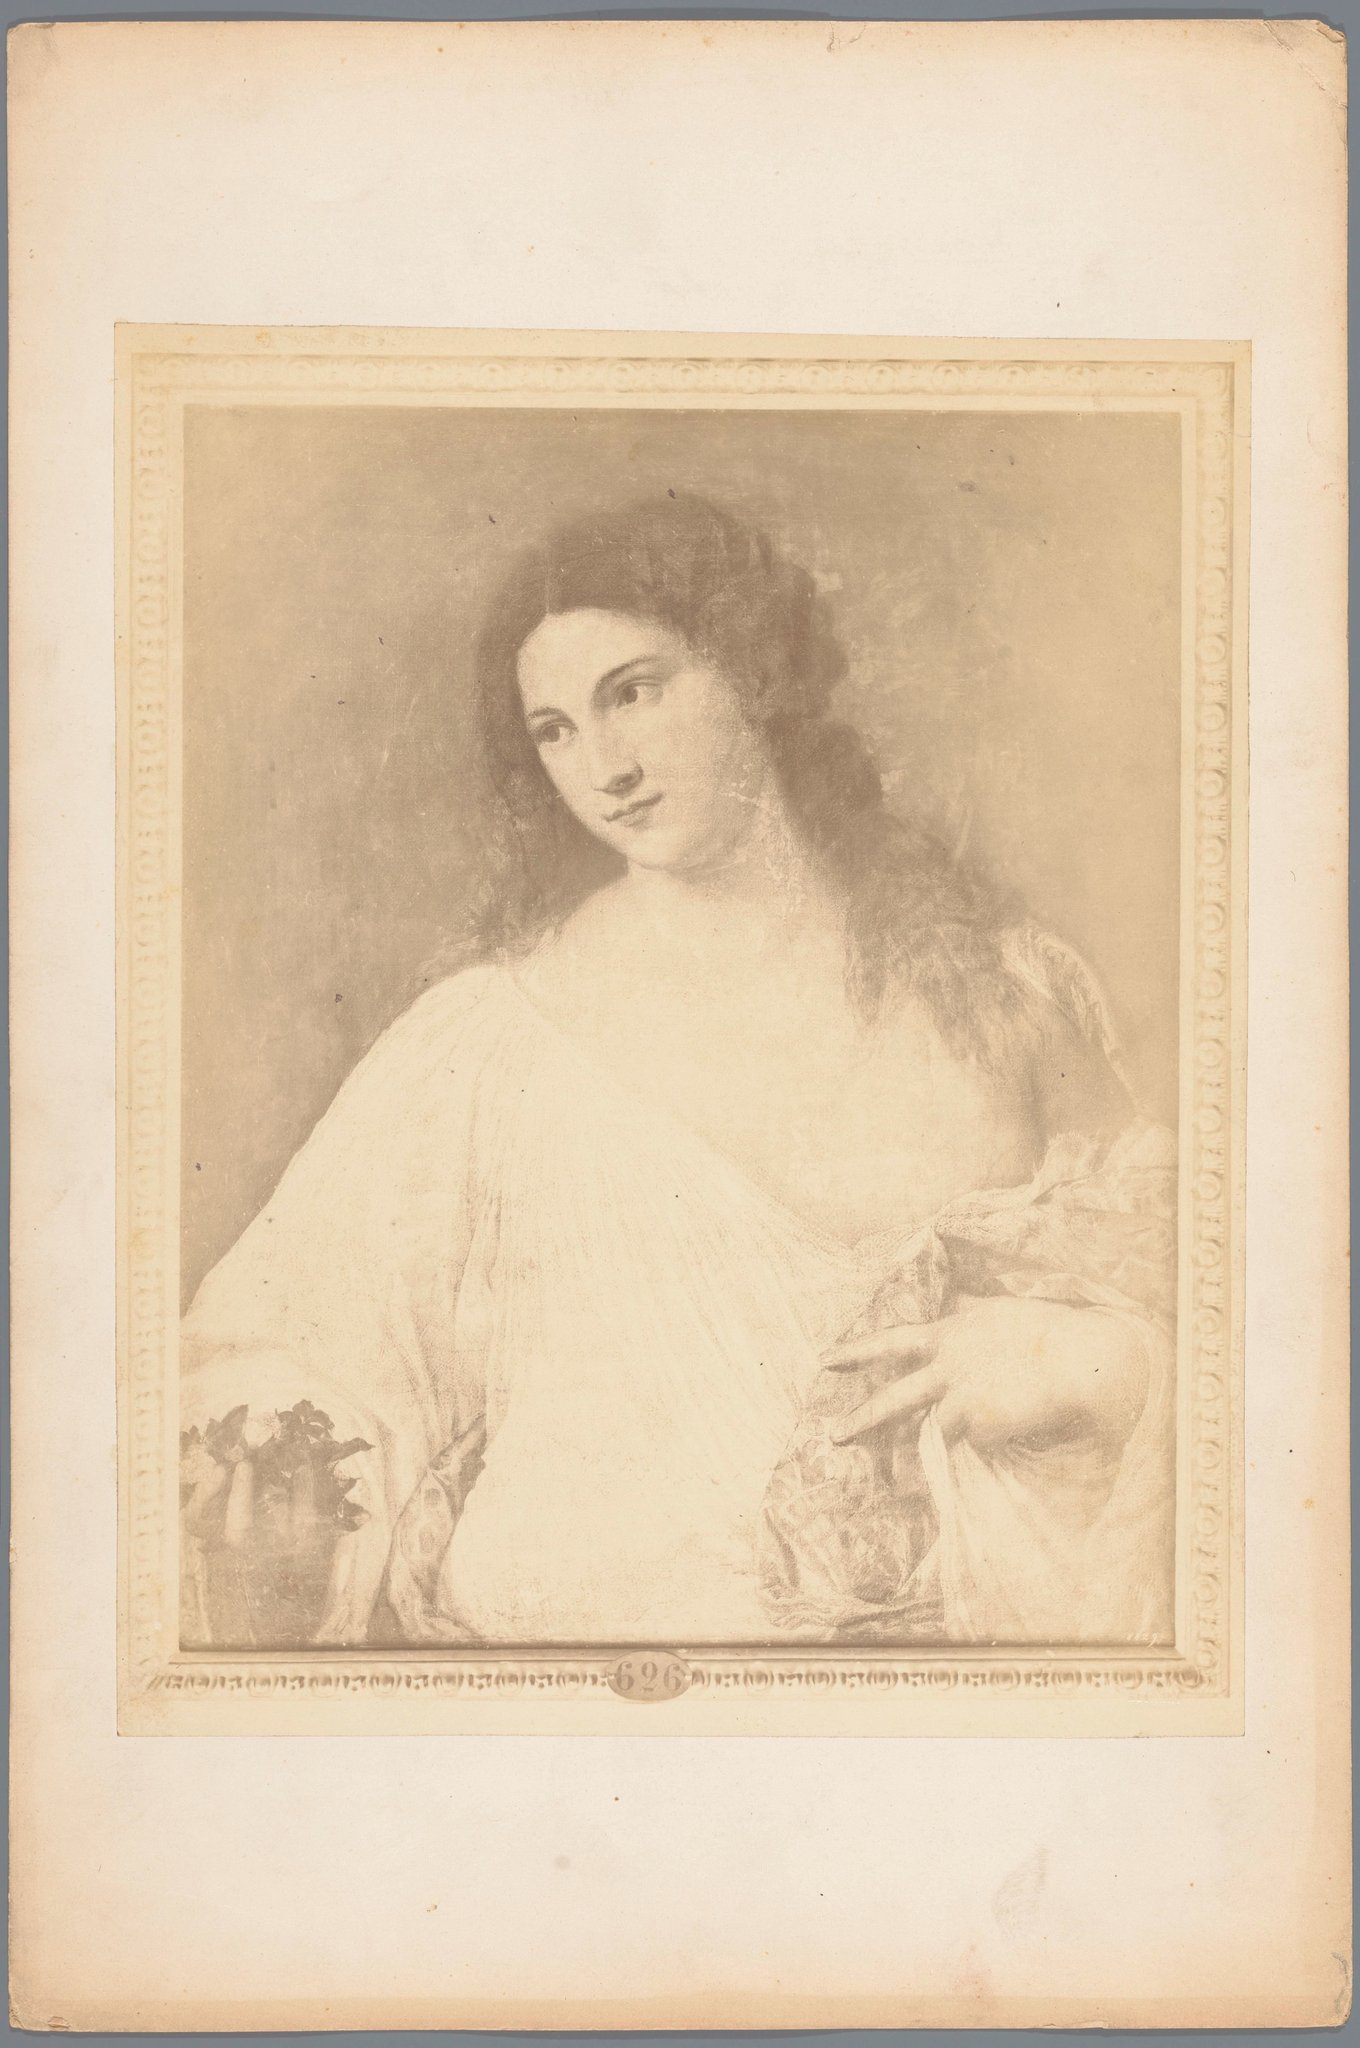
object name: reproduction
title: Fotoreproductie van een schilderij, voorstellende een portret van een half ontblote vrouw met bloemen in de hand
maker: Anonymous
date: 1875-1900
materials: cardboard, photographic support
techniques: albumen print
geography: europe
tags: flowers, woman (showing herself) undressed, quasi-nude, anonymous historical person portrayed - bb - woman, europe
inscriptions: name: ‘ALINARI’, number: ‘8829’, collector's mark: Lugt 3937